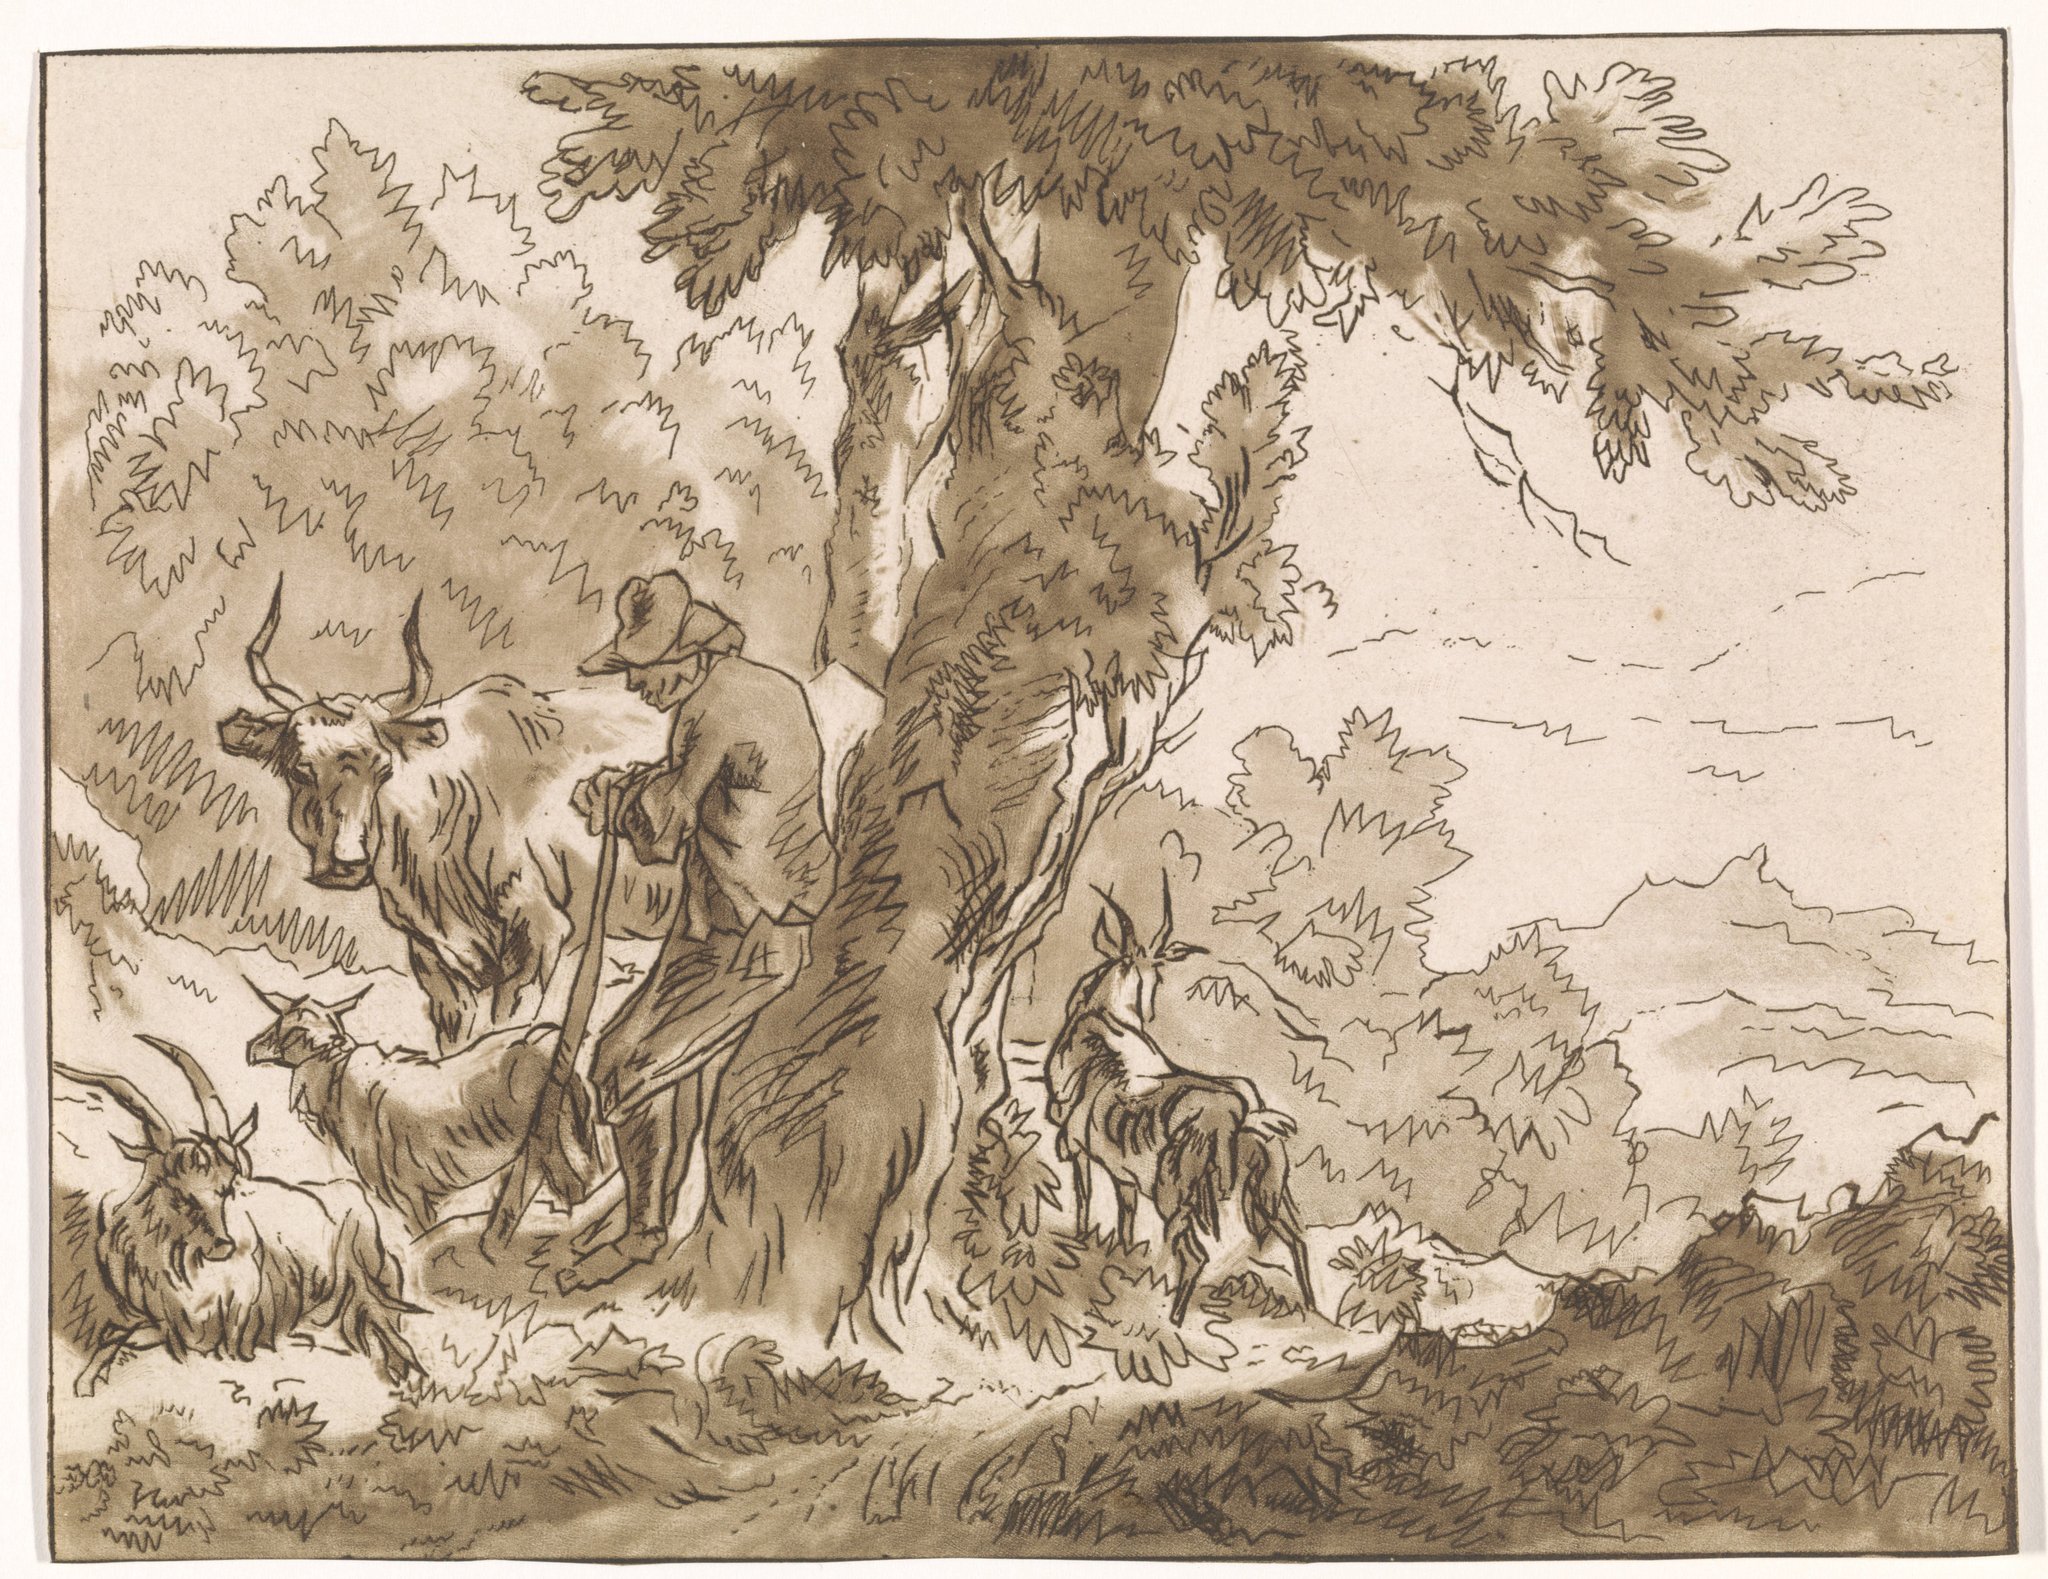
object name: print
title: Herder en zijn vee bij een boom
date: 1770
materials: paper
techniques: aquatint, etching, roulette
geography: amsterdam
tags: herding, herdsman, herdswoman, shepherd, shepherdess, cowherd, etc., leaning figure, herd, flock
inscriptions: collector's mark: Lugt 240, inscription: ‘Jacob van de Velde ft. 1770 na N. Berchem’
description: Herder die tegen een boom leunt, om hem heen staat zijn vee.